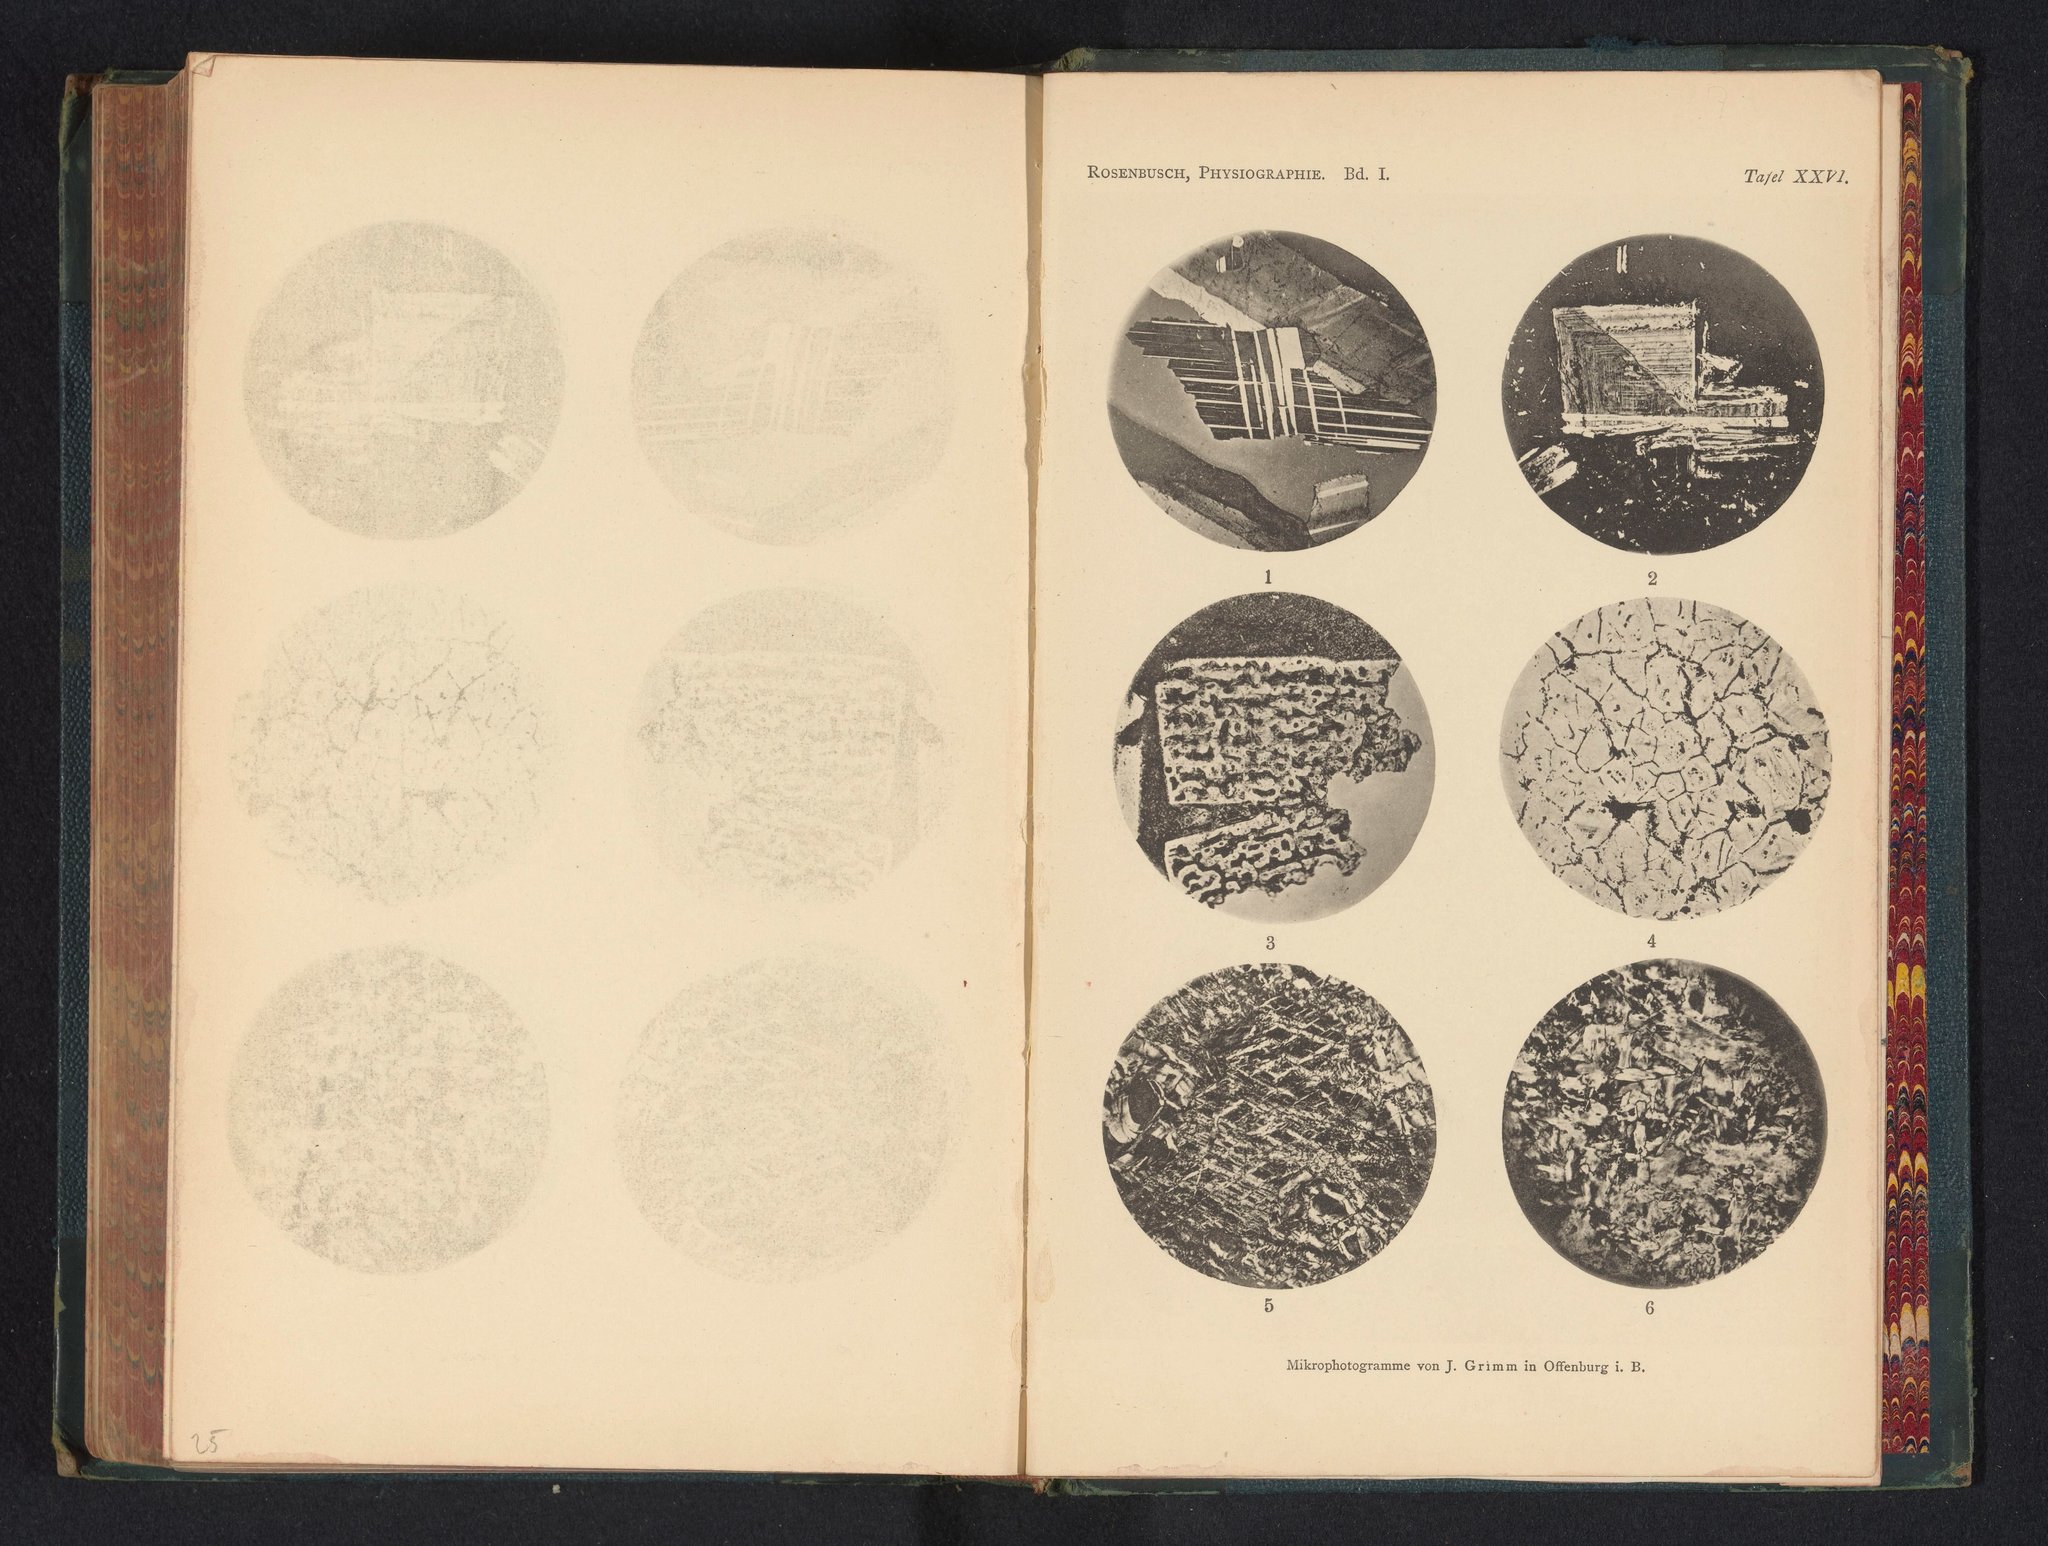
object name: page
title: Zes microscopische vergrotingen van mineralen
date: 1880-1885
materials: paper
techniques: photograph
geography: offenburg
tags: minerals and metals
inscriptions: number: ‘Tafel XXVI’, number: ‘1 (...) 6’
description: Afbeelding 1,2 en 3 is plagioklaas, 4, 5 en 6 is serpentine.